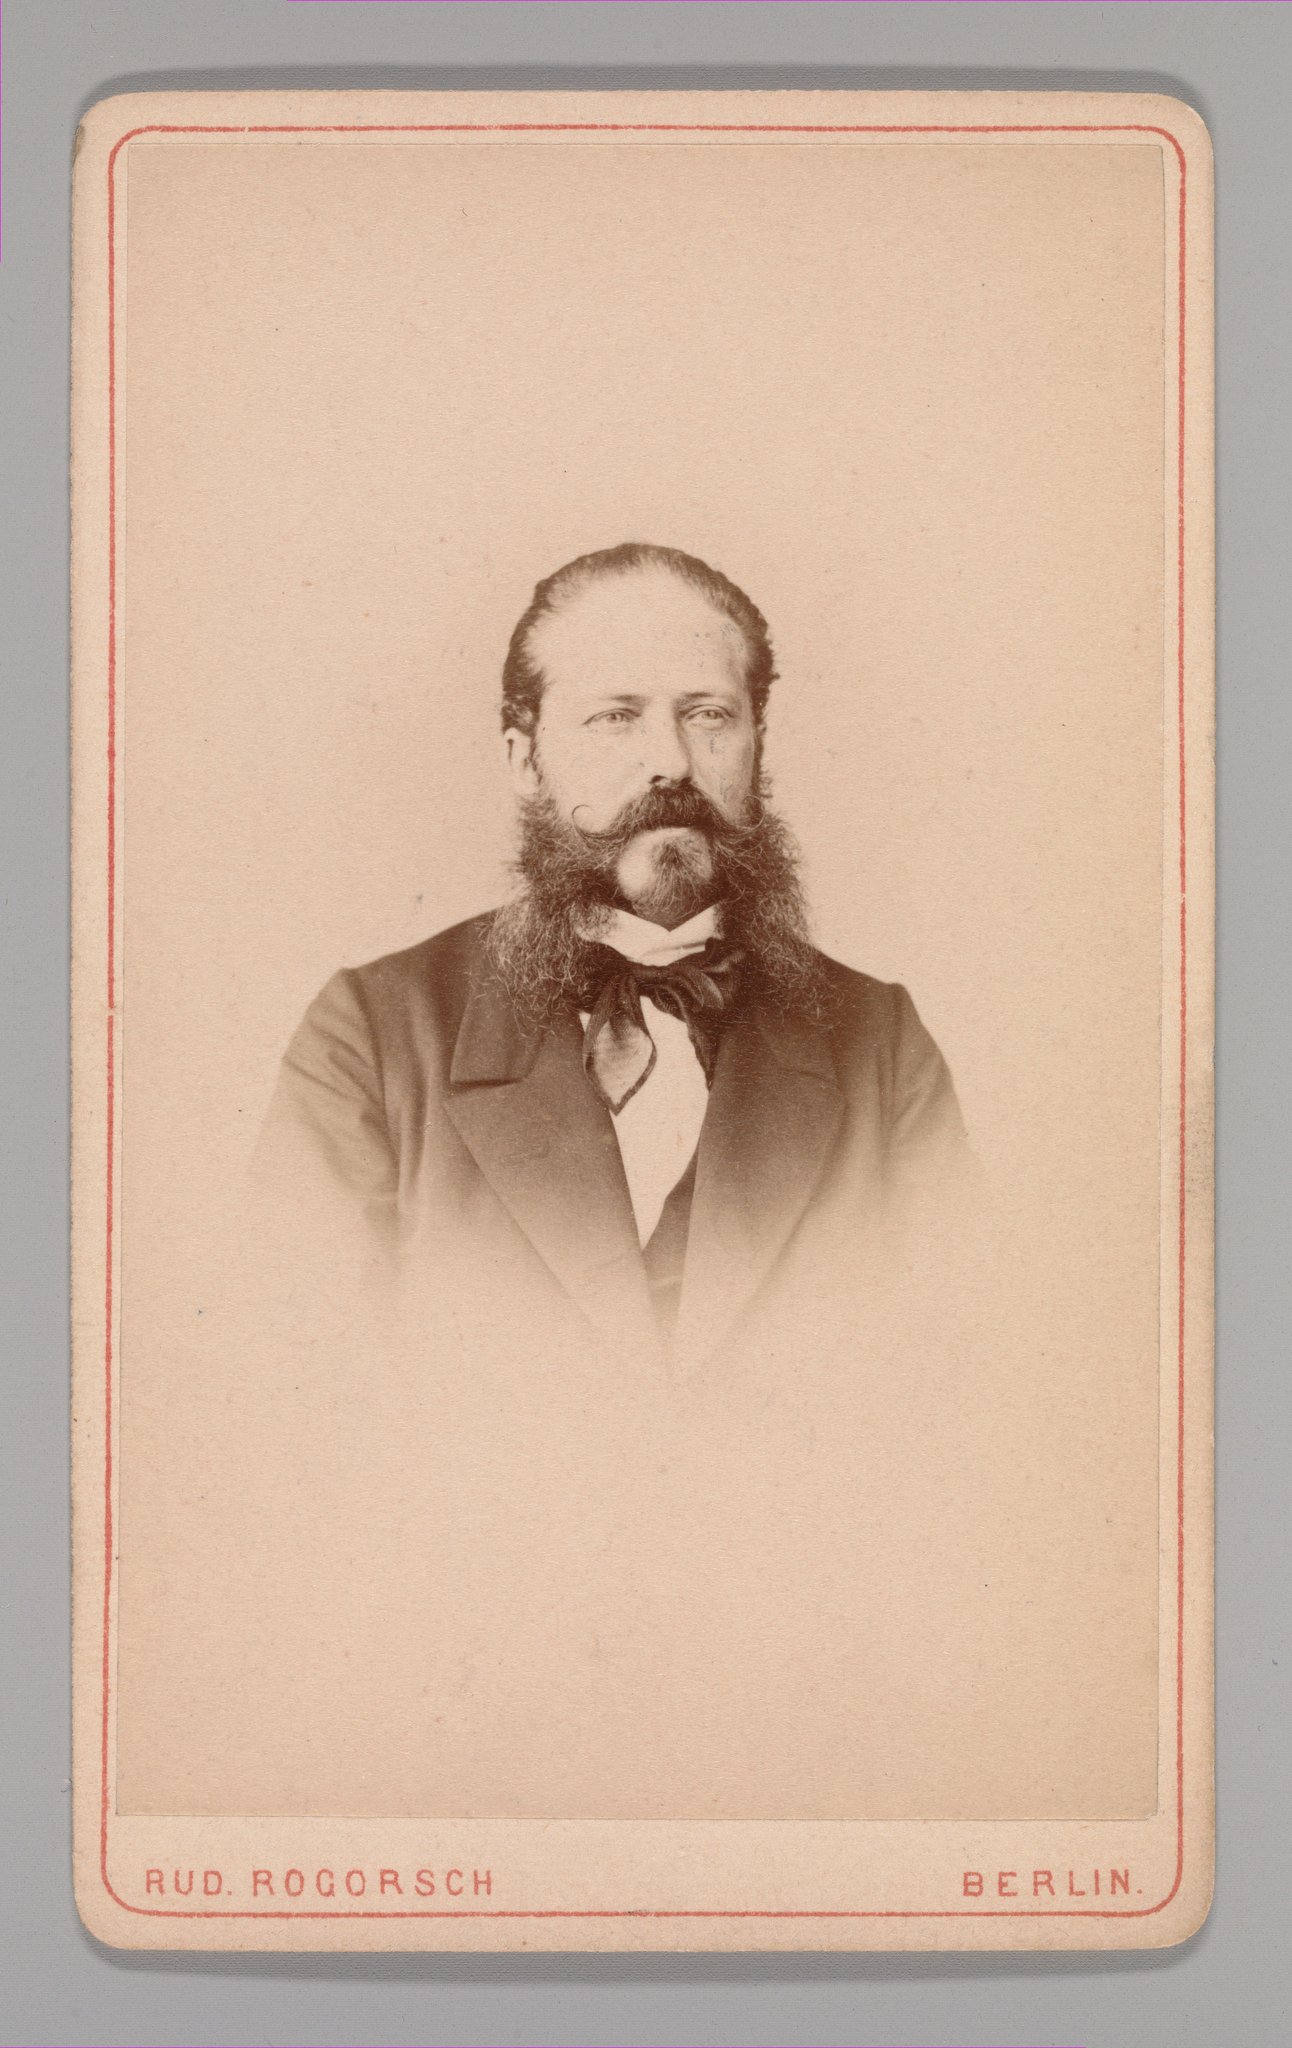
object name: carte de visite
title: [Eduard Hildebrandt]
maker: rudolph rogorsh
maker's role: artist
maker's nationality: german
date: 1860-1869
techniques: albumen silver print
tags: men,portraits